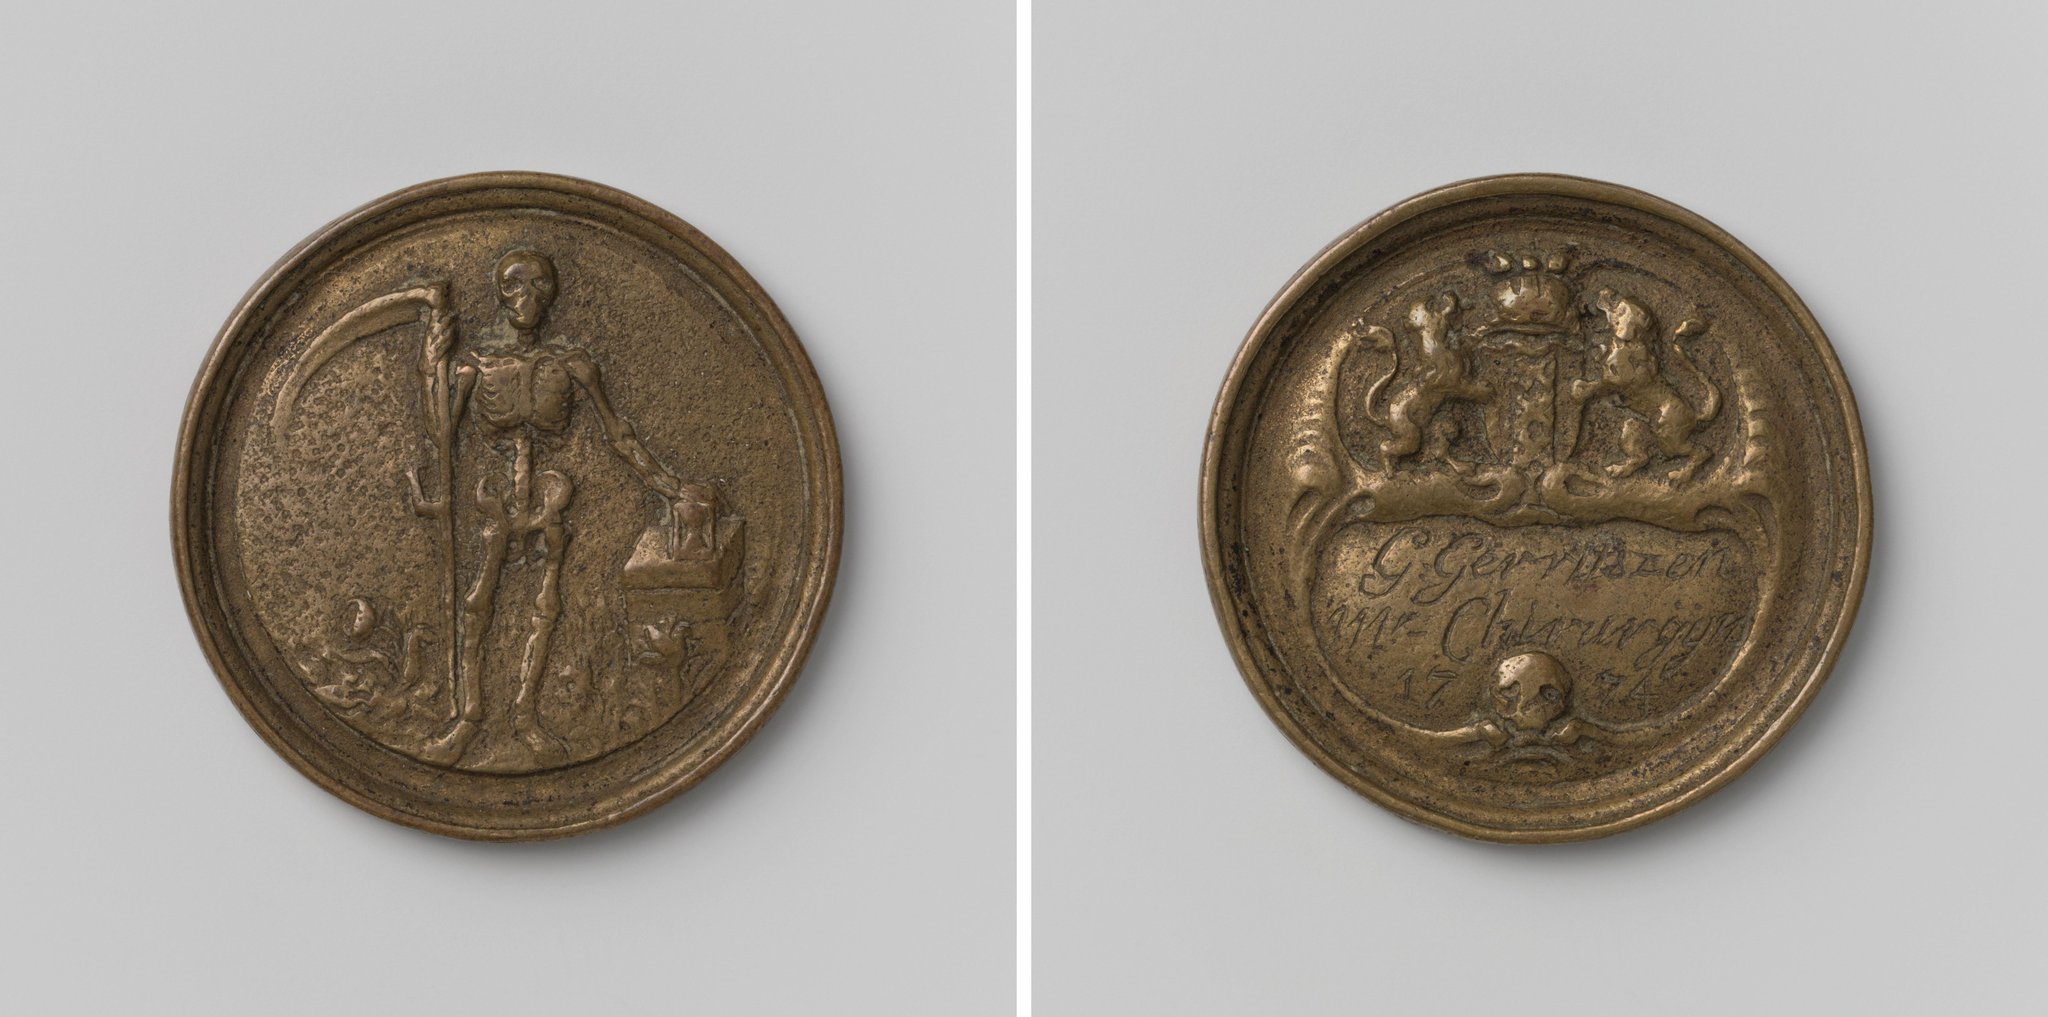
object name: medal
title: Chirurgijnsgilde van Amsterdam, gildepenning van G. Gerritszen, 111de chirurgijn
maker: Anonymous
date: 1774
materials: brass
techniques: casting, engraving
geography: amsterdam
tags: amsterdam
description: Messing penning. Voorzijde: Dood, afgebeeld als geraamte, in bloemenveld met zeis in rechterhand en met linkerhand op zandloper, die op sokkel staat. Keerzijde: gekroond wapenschild, geflankeerd door twee leeuwen boven cartouche met opschrift en doodshoofd